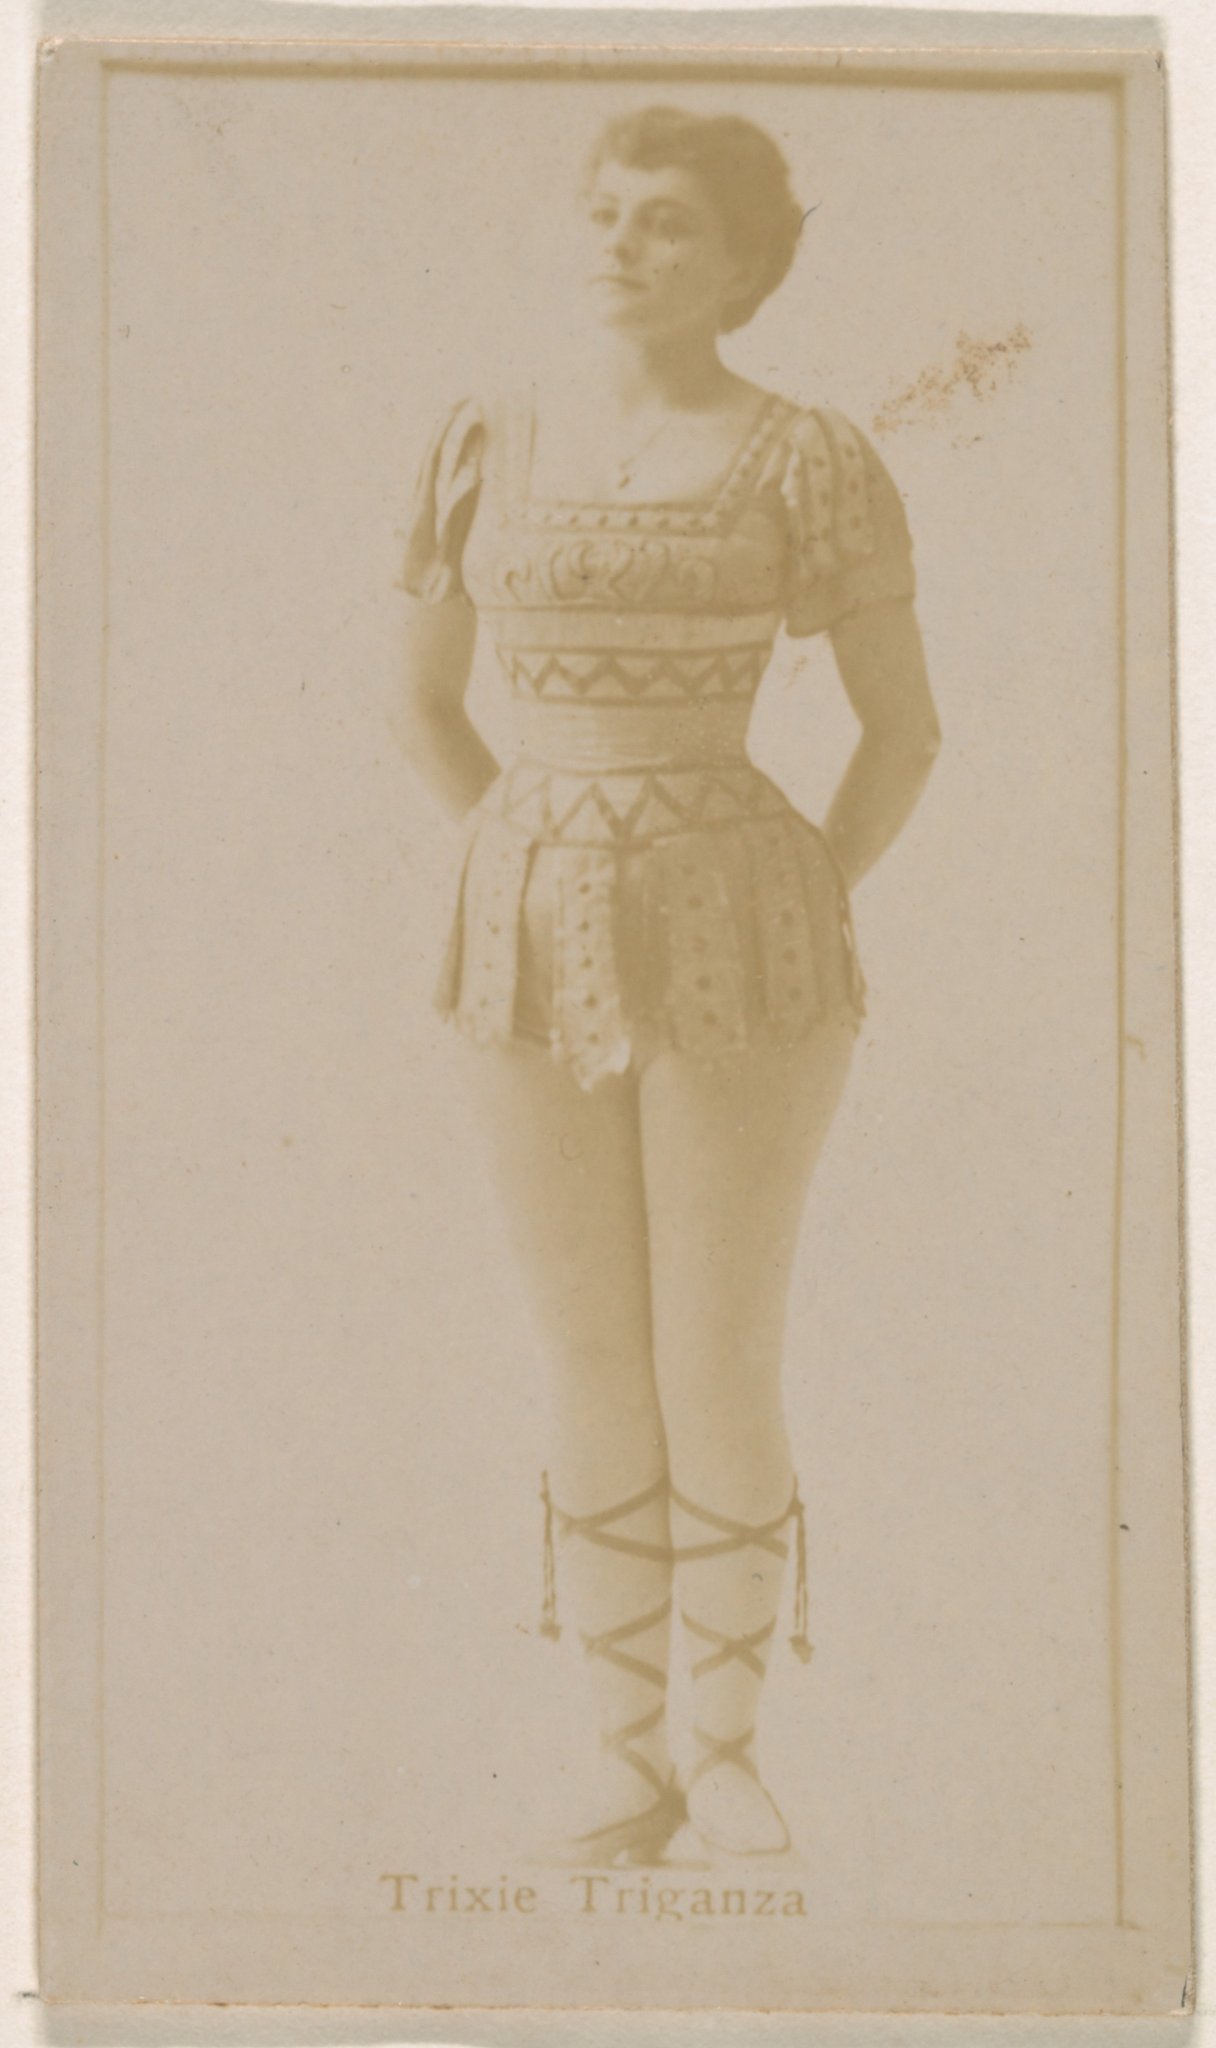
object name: photograph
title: Trixie Triganza, from the Actresses series (N245) issued by Kinney Brothers to promote Sweet Caporal Cigarettes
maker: kinney brothers tobacco company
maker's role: publisher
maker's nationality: american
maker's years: 1869-2011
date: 1890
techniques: albumen silver print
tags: portraits,women,actresses